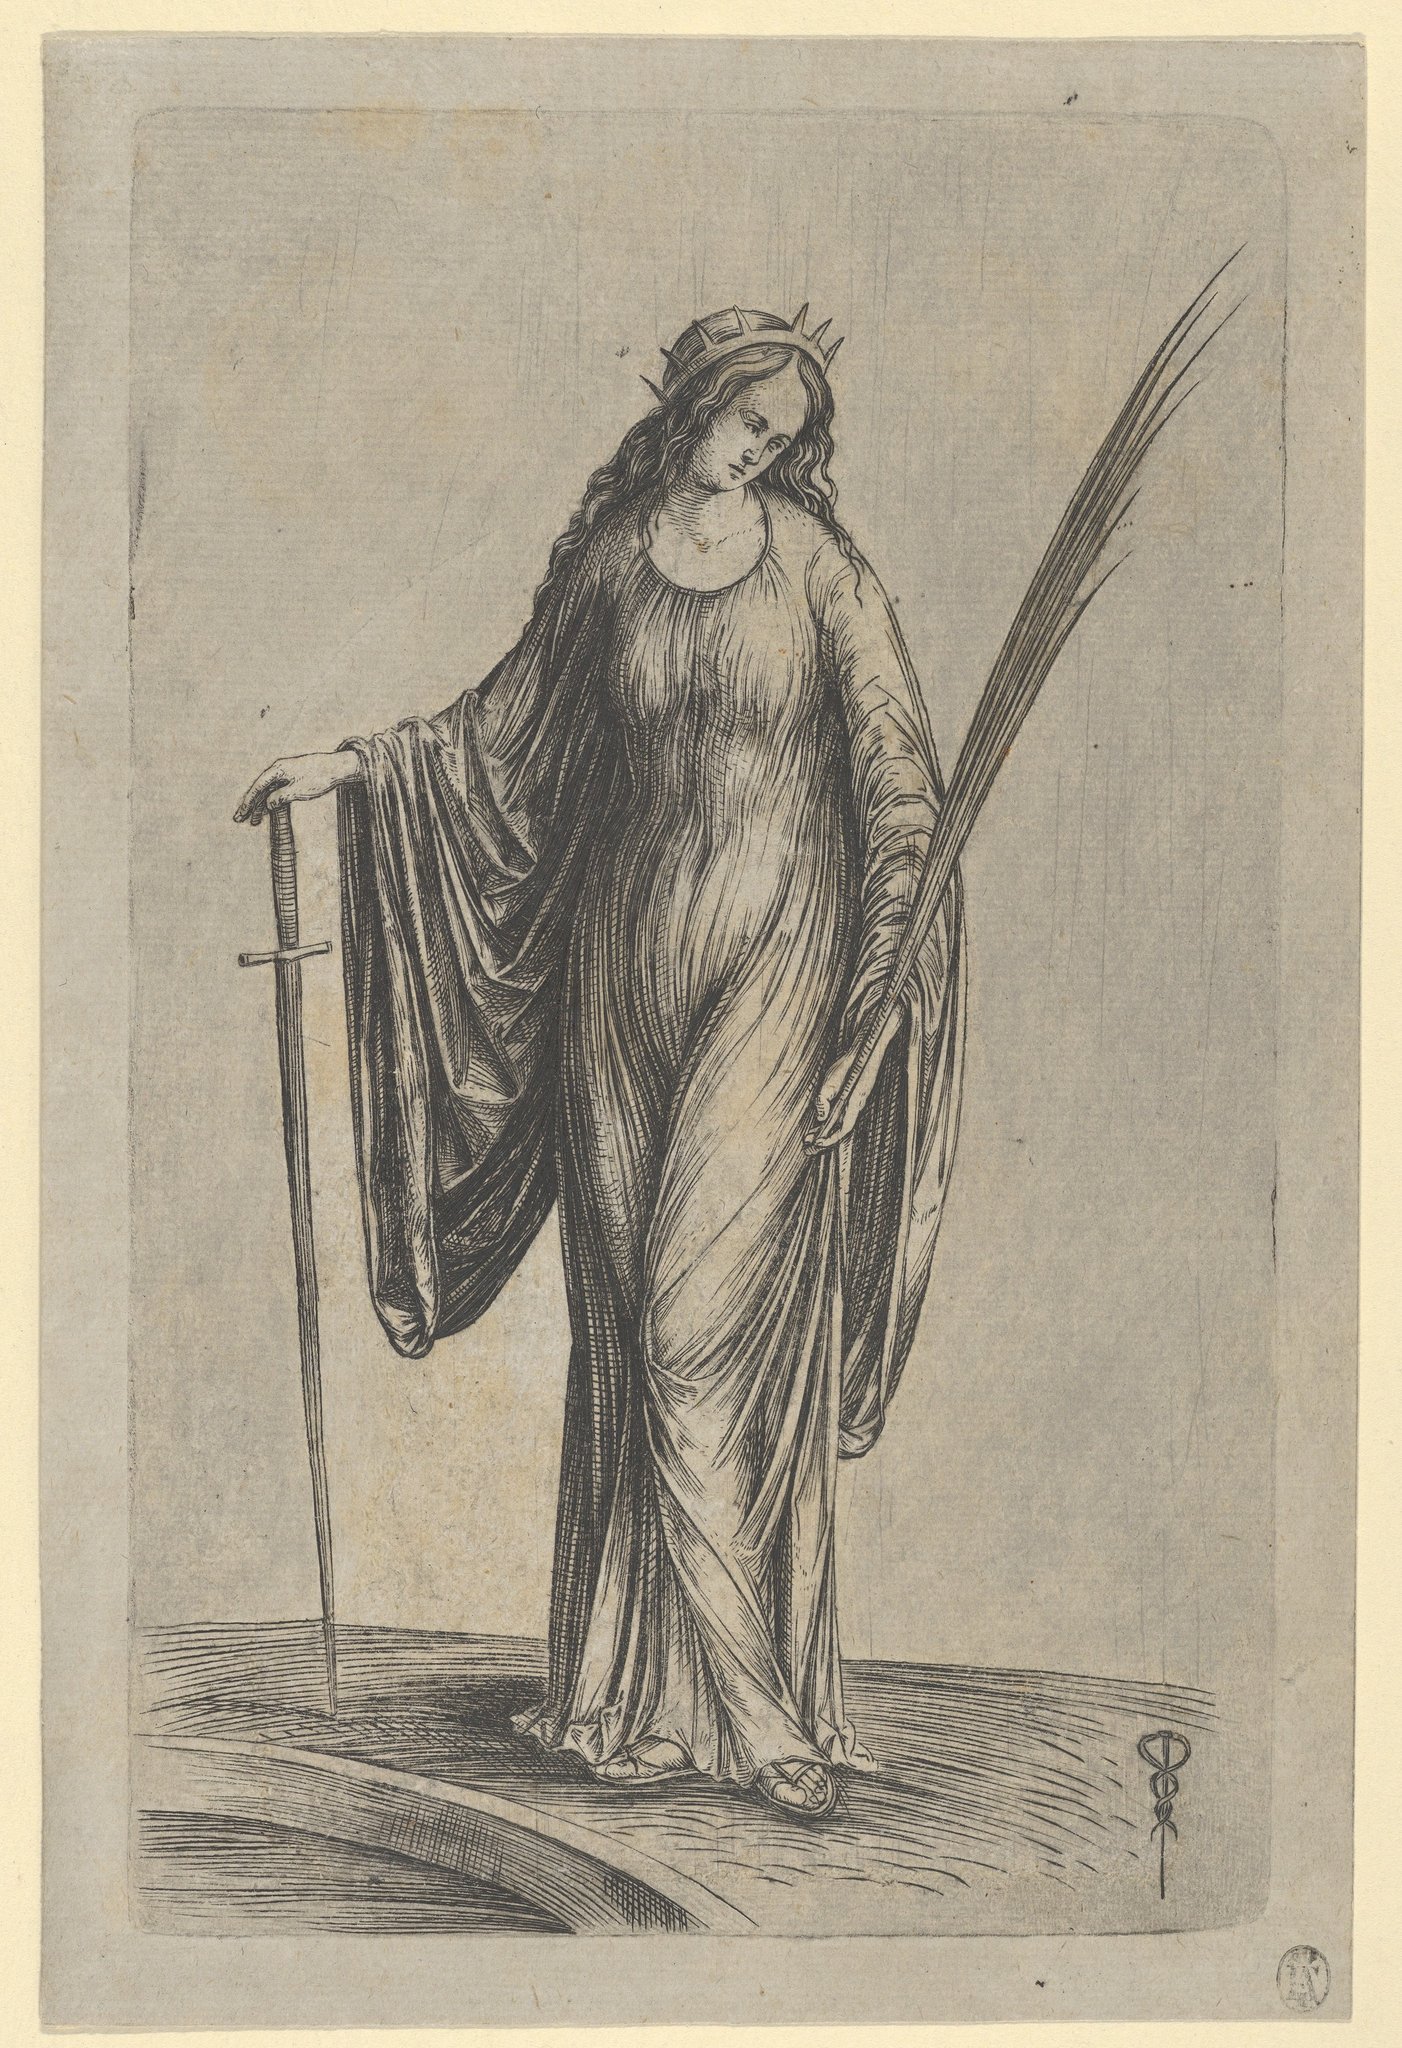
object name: print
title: Saint Catherine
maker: jacopo de barbari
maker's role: artist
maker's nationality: italian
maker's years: 1497-1516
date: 1501-1503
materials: paper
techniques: engraving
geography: venice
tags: swords,saint catherine